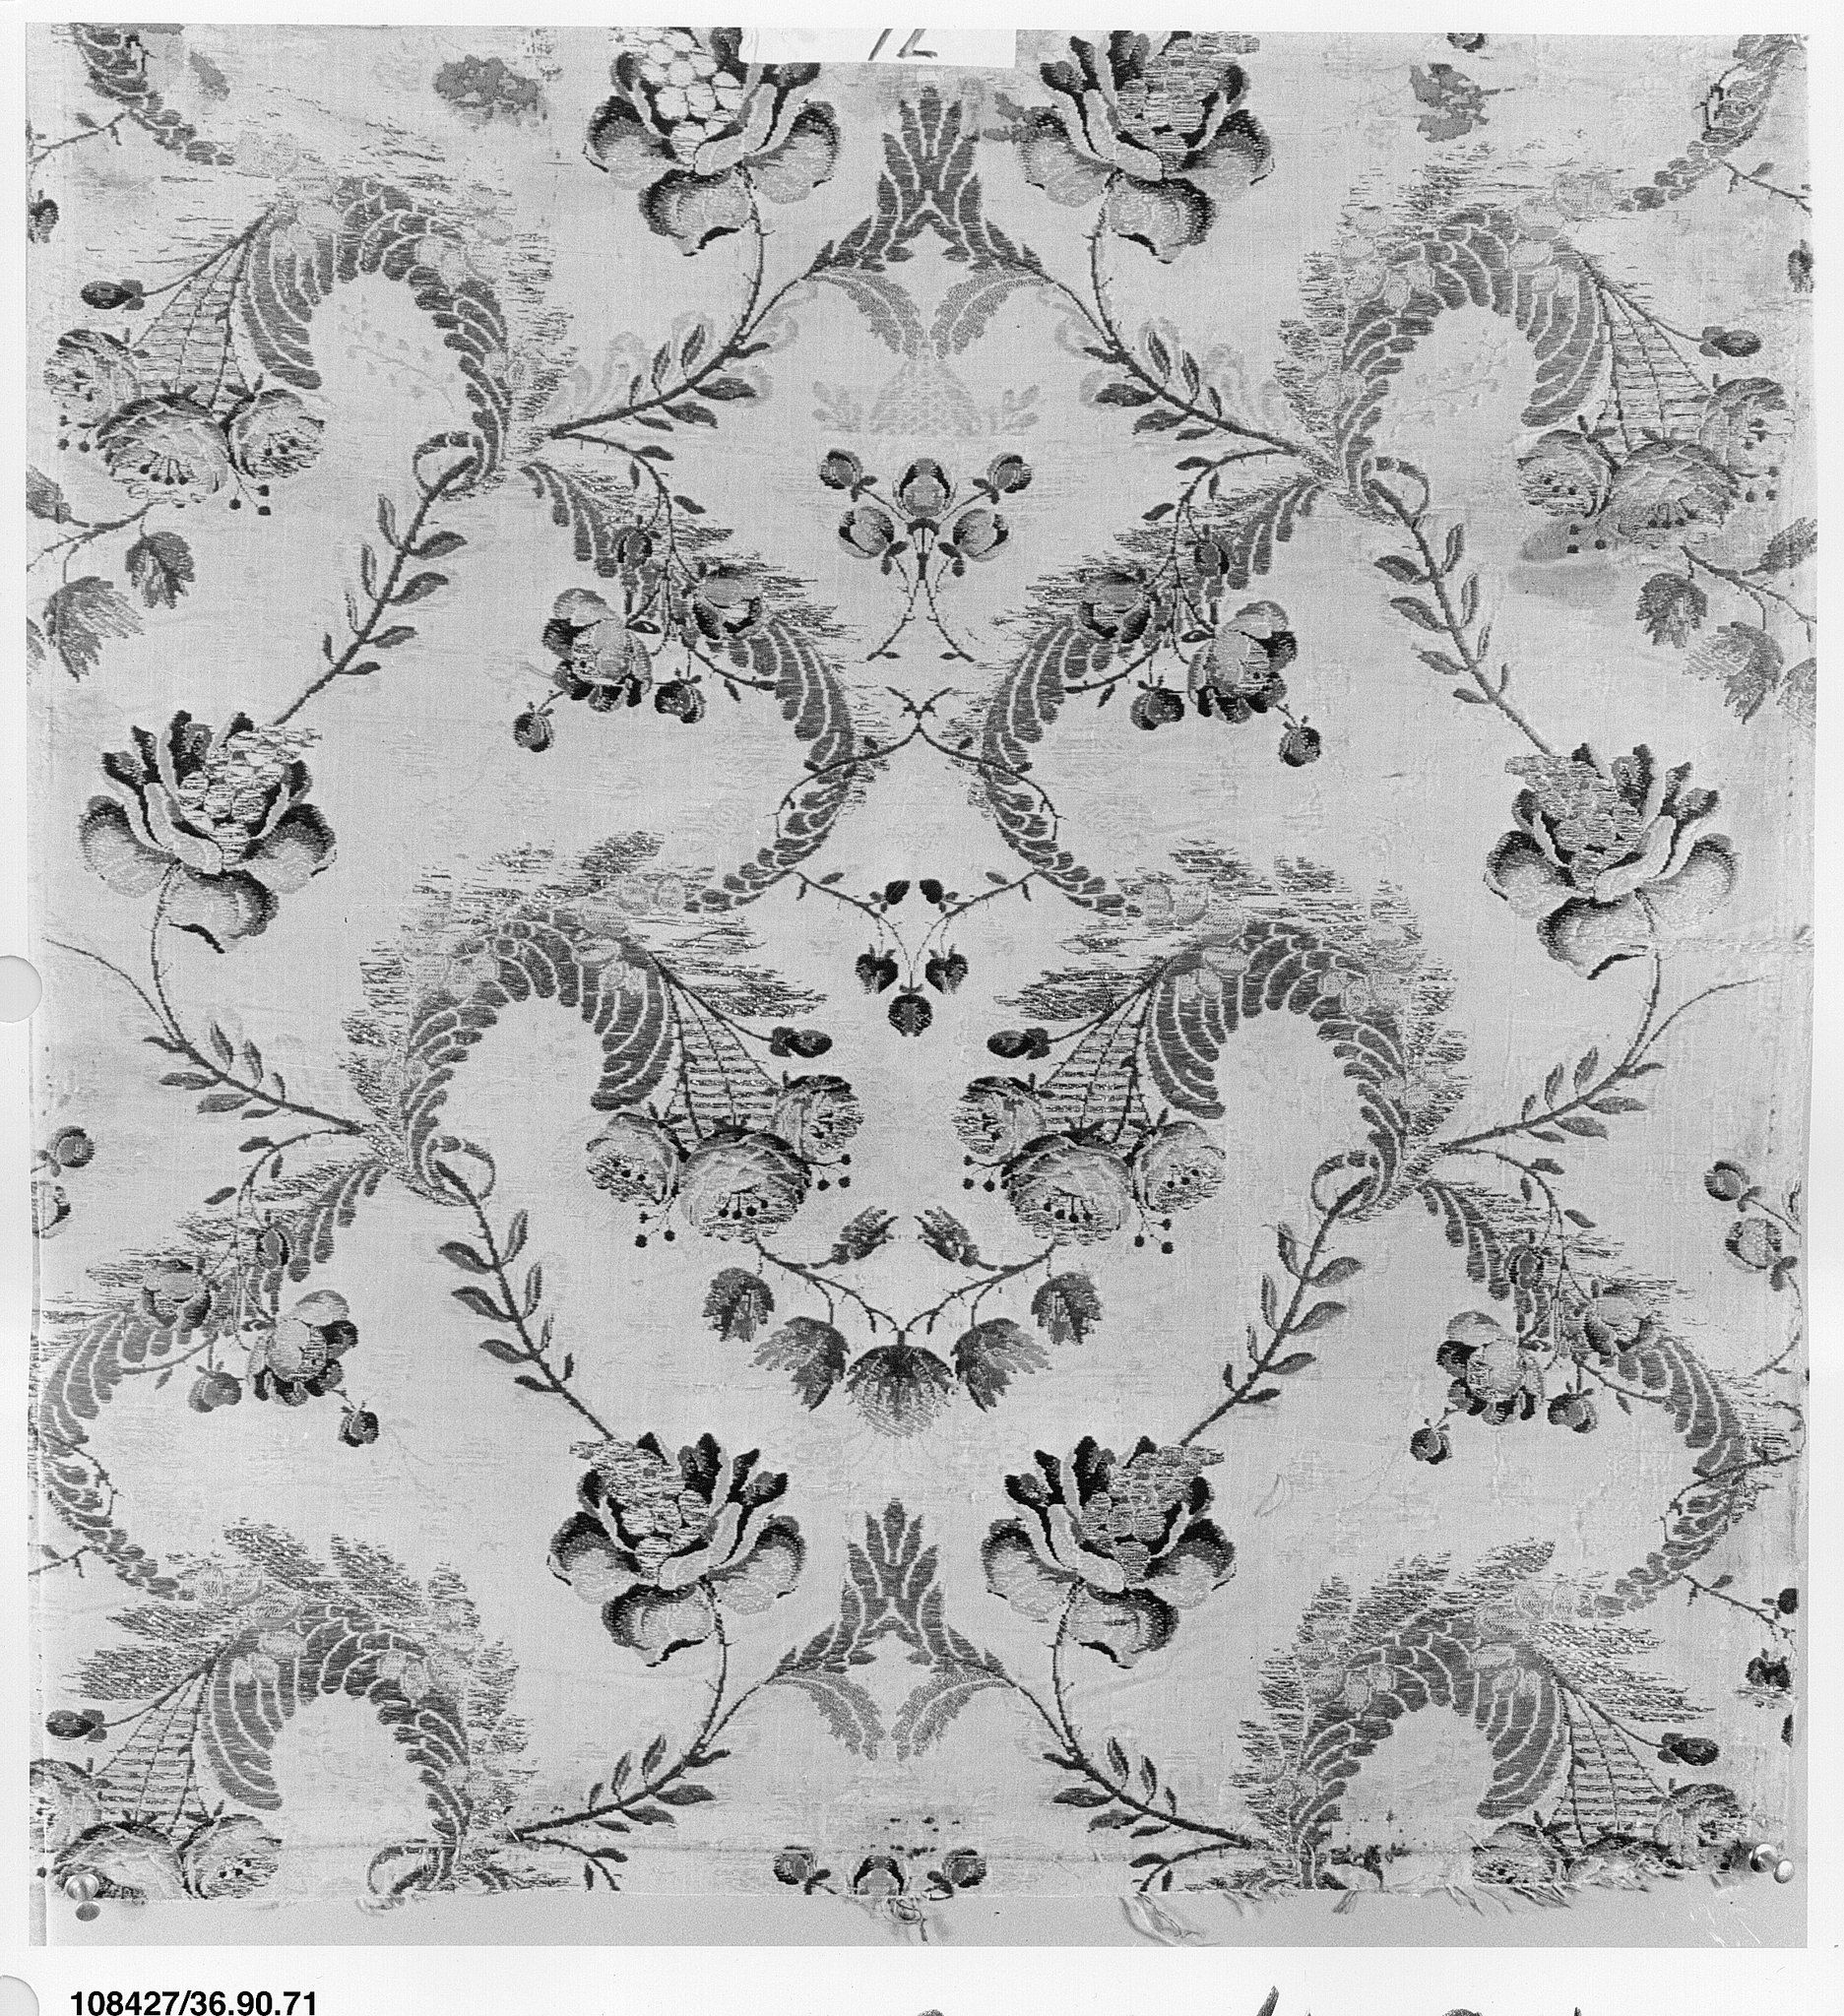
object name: piece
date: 1734-1766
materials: metal thread, silk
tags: flowers,leaves